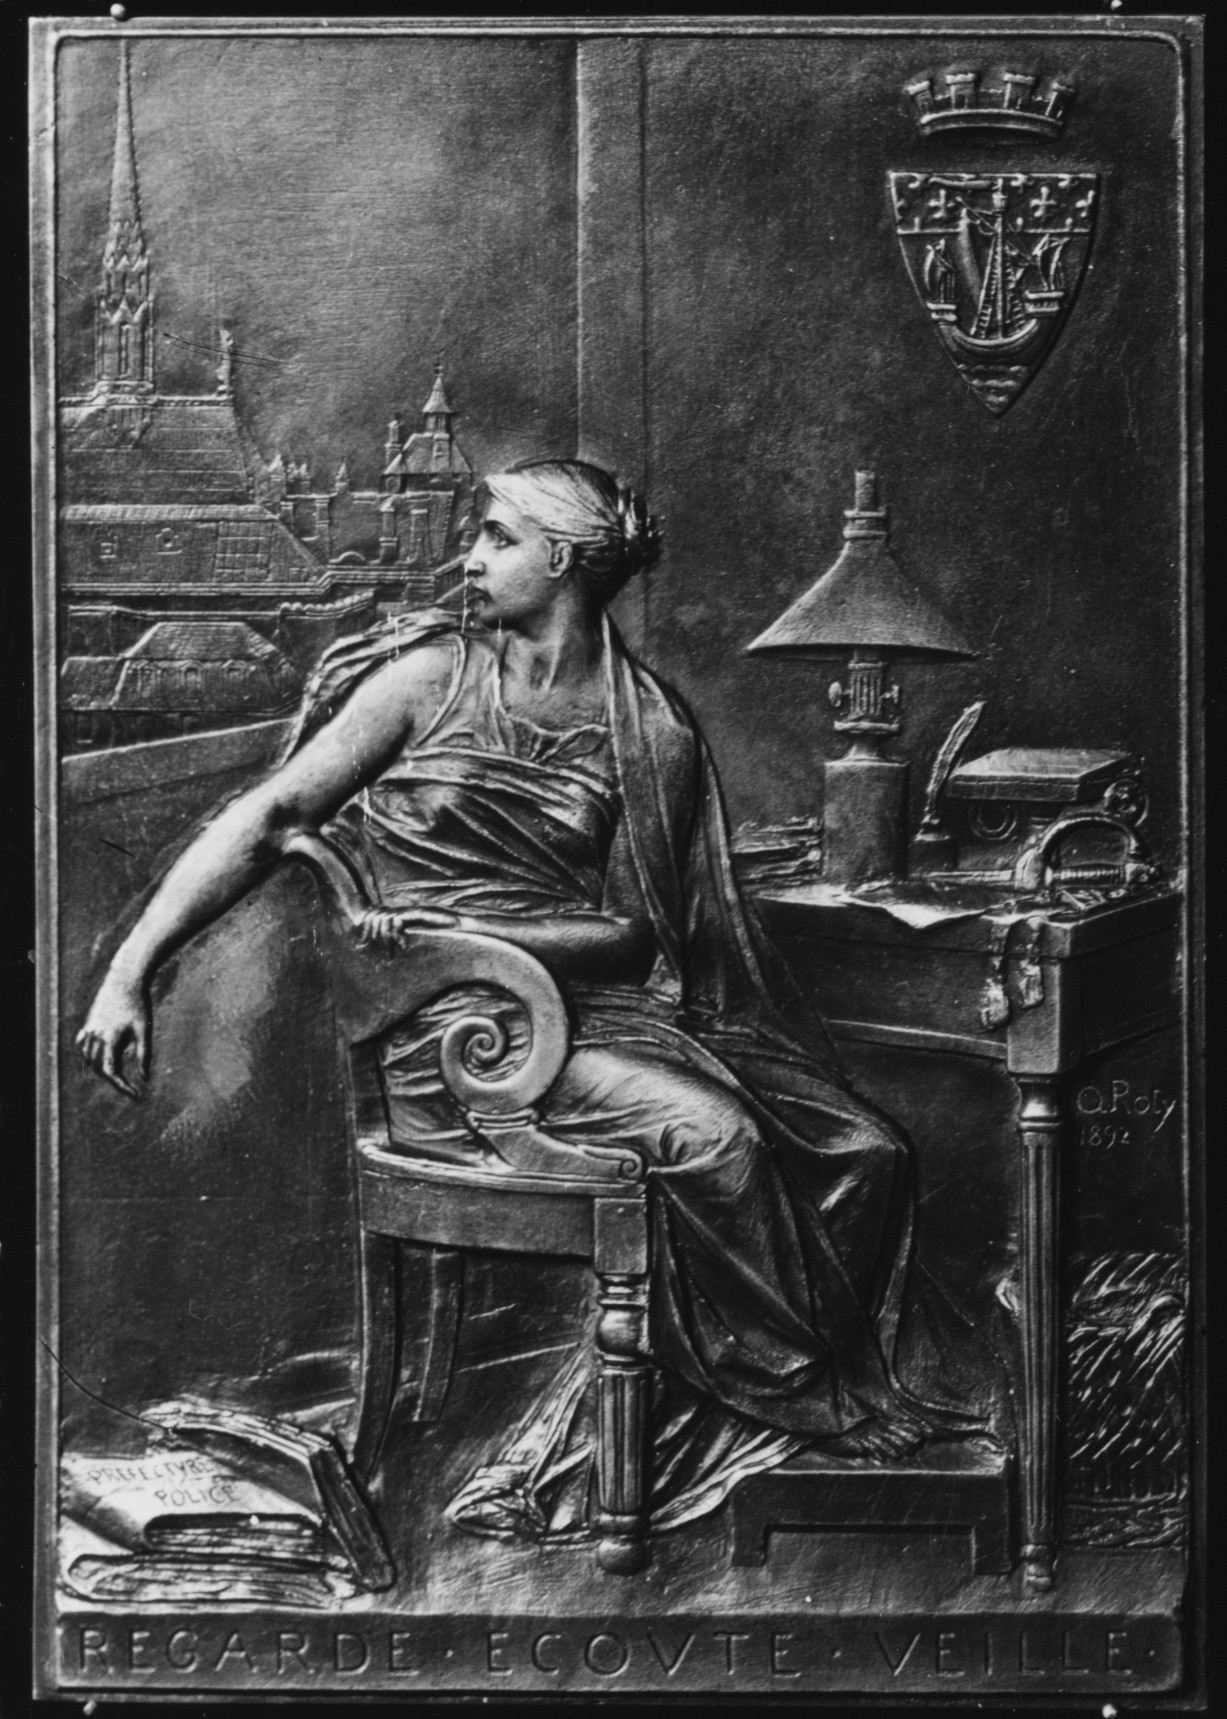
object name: plaquette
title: In Honor of Henry Lozé, Prefect of Police of Paris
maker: louis-oscar roty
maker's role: artist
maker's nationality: french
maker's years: 1846-1911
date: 1892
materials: bronze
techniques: silvered, struck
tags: women,coat of arms